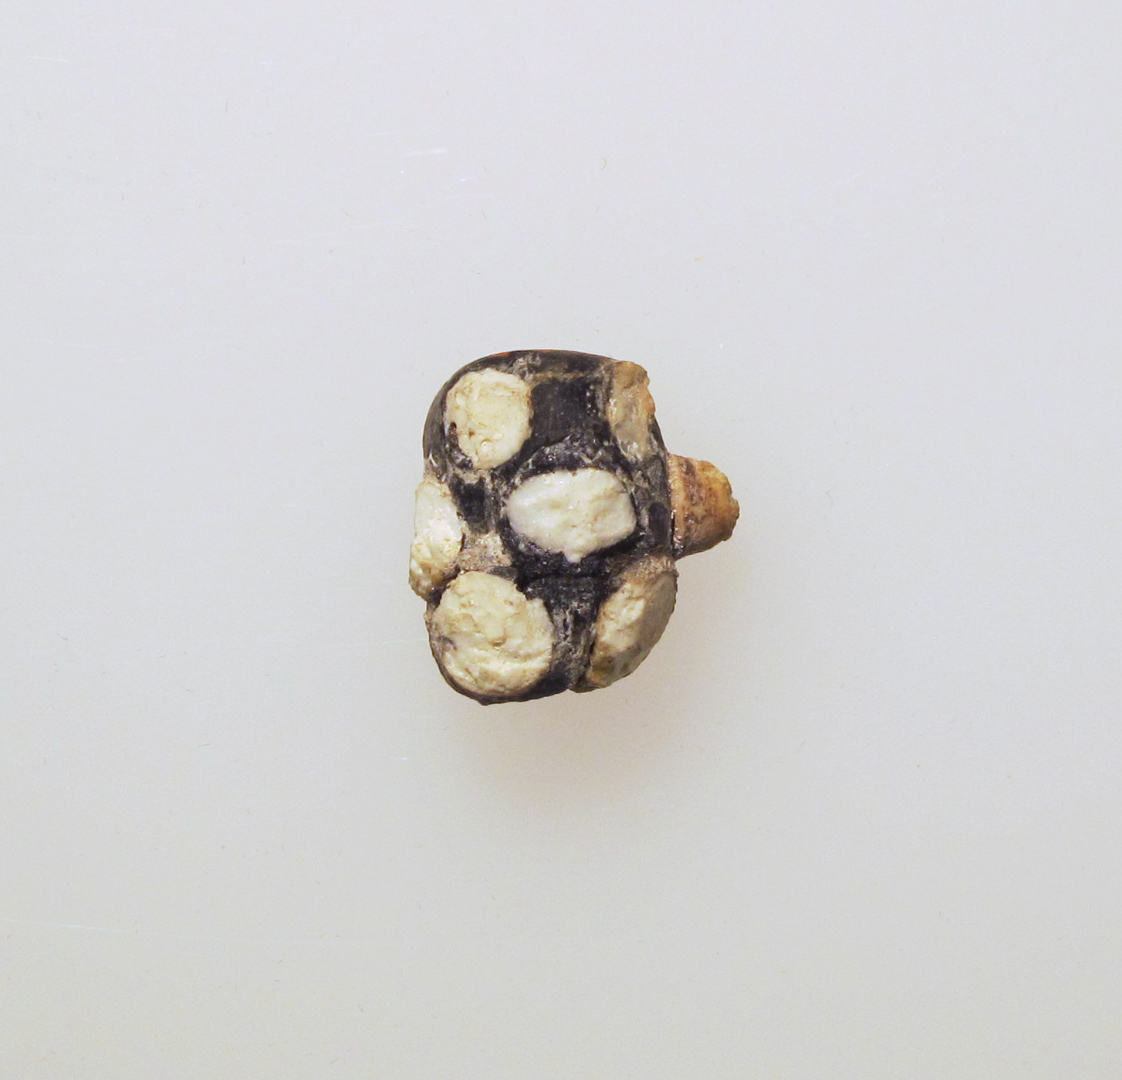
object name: bead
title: Glass bead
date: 7000 BCE-330 CE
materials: glass